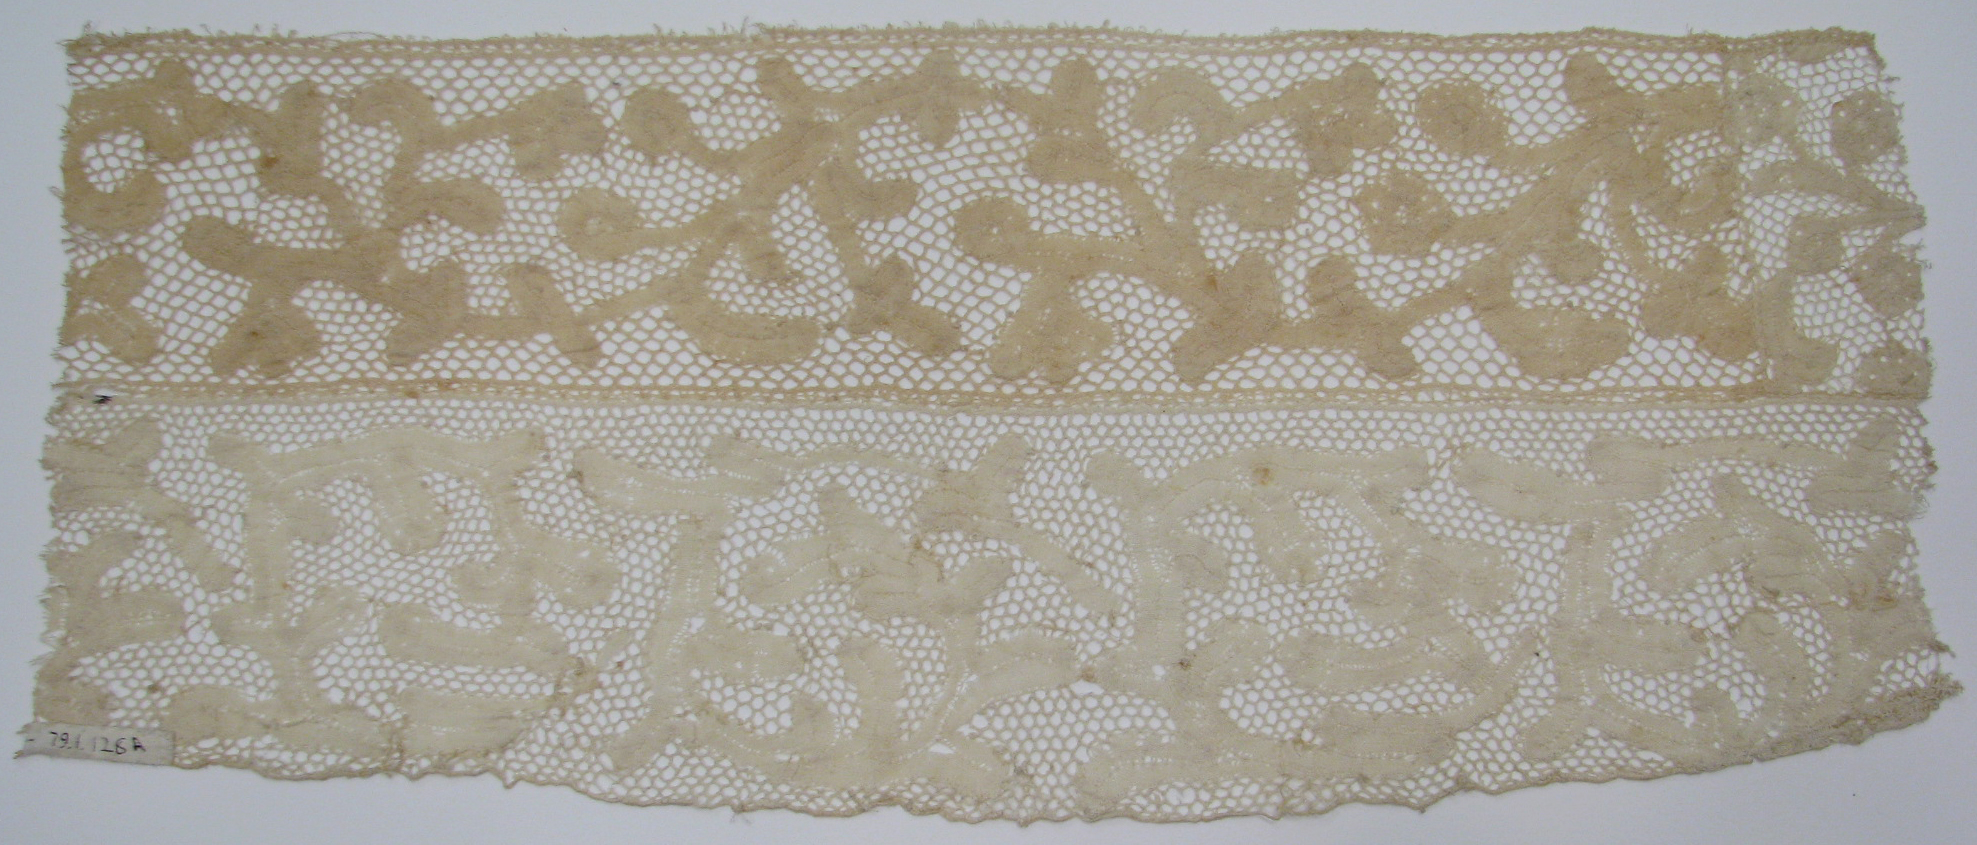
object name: fragment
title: Fragment of Point de Milan lace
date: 1601-1800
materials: lace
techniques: lace